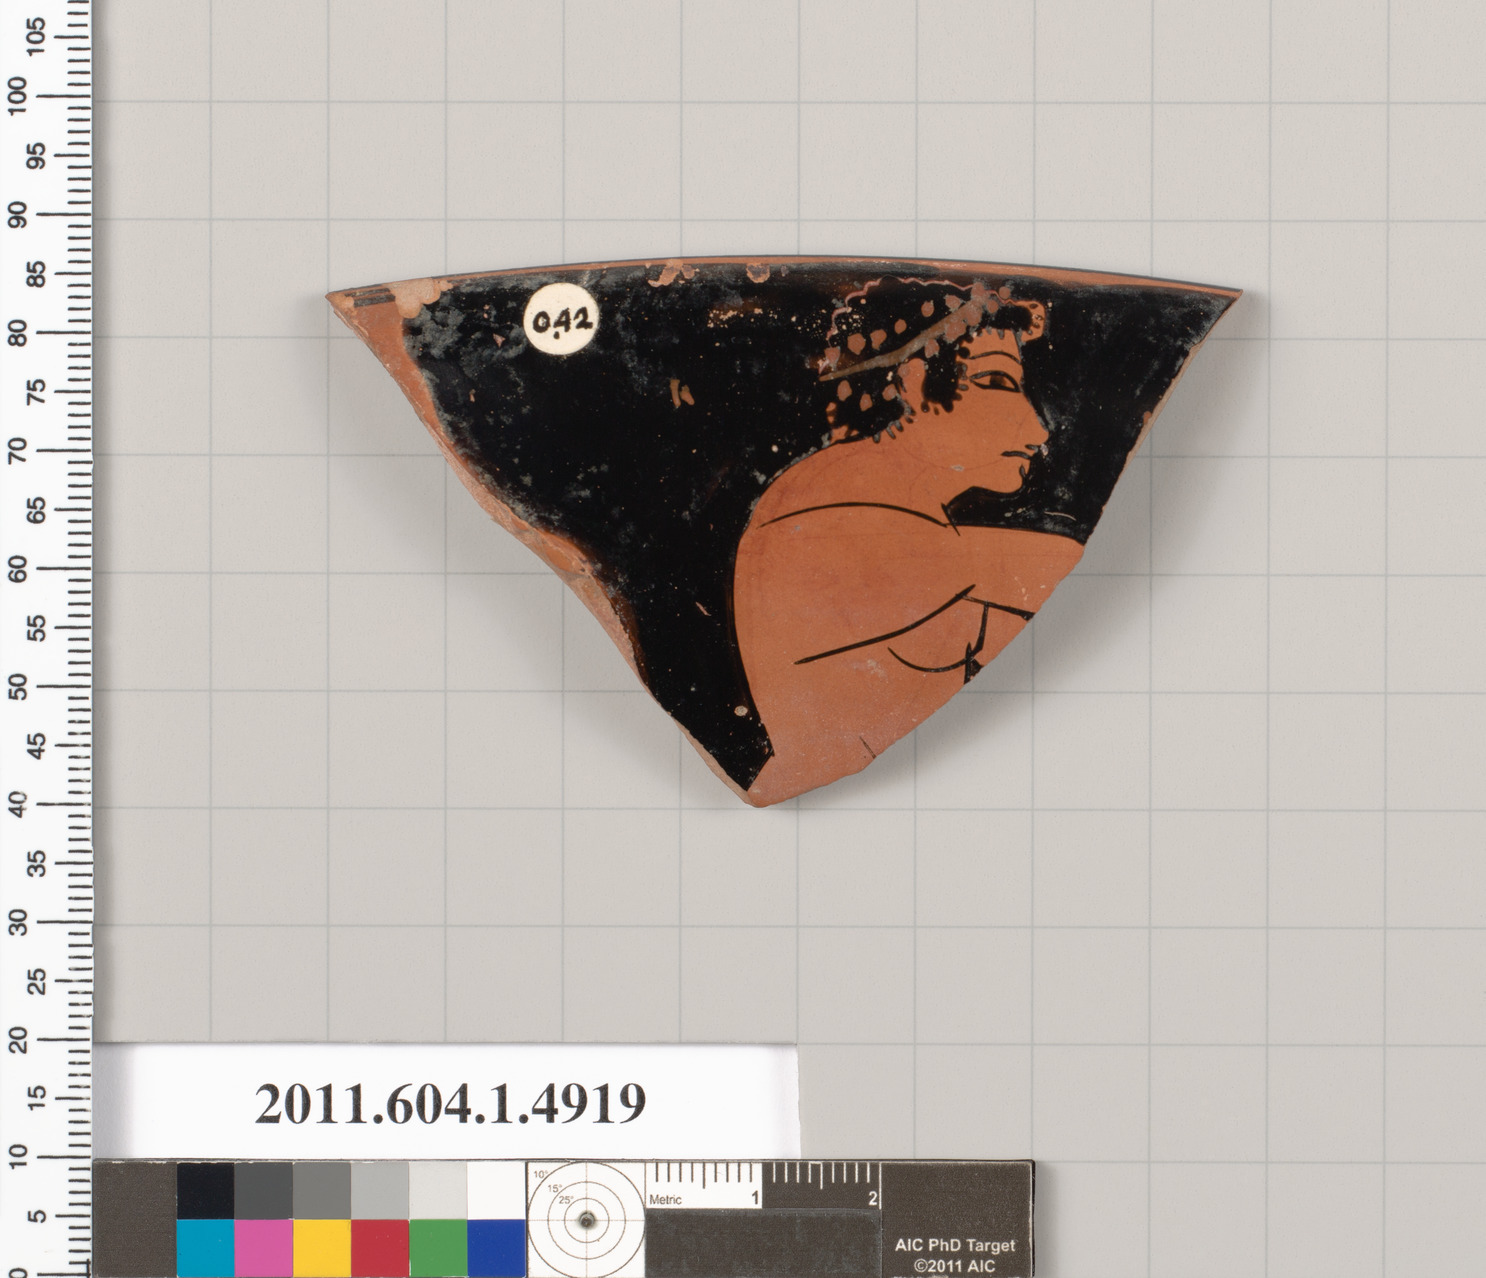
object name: kylix fragment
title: Terracotta rim fragment of a kylix (drinking cup)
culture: greek, attic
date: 520-500 BCE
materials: terracotta